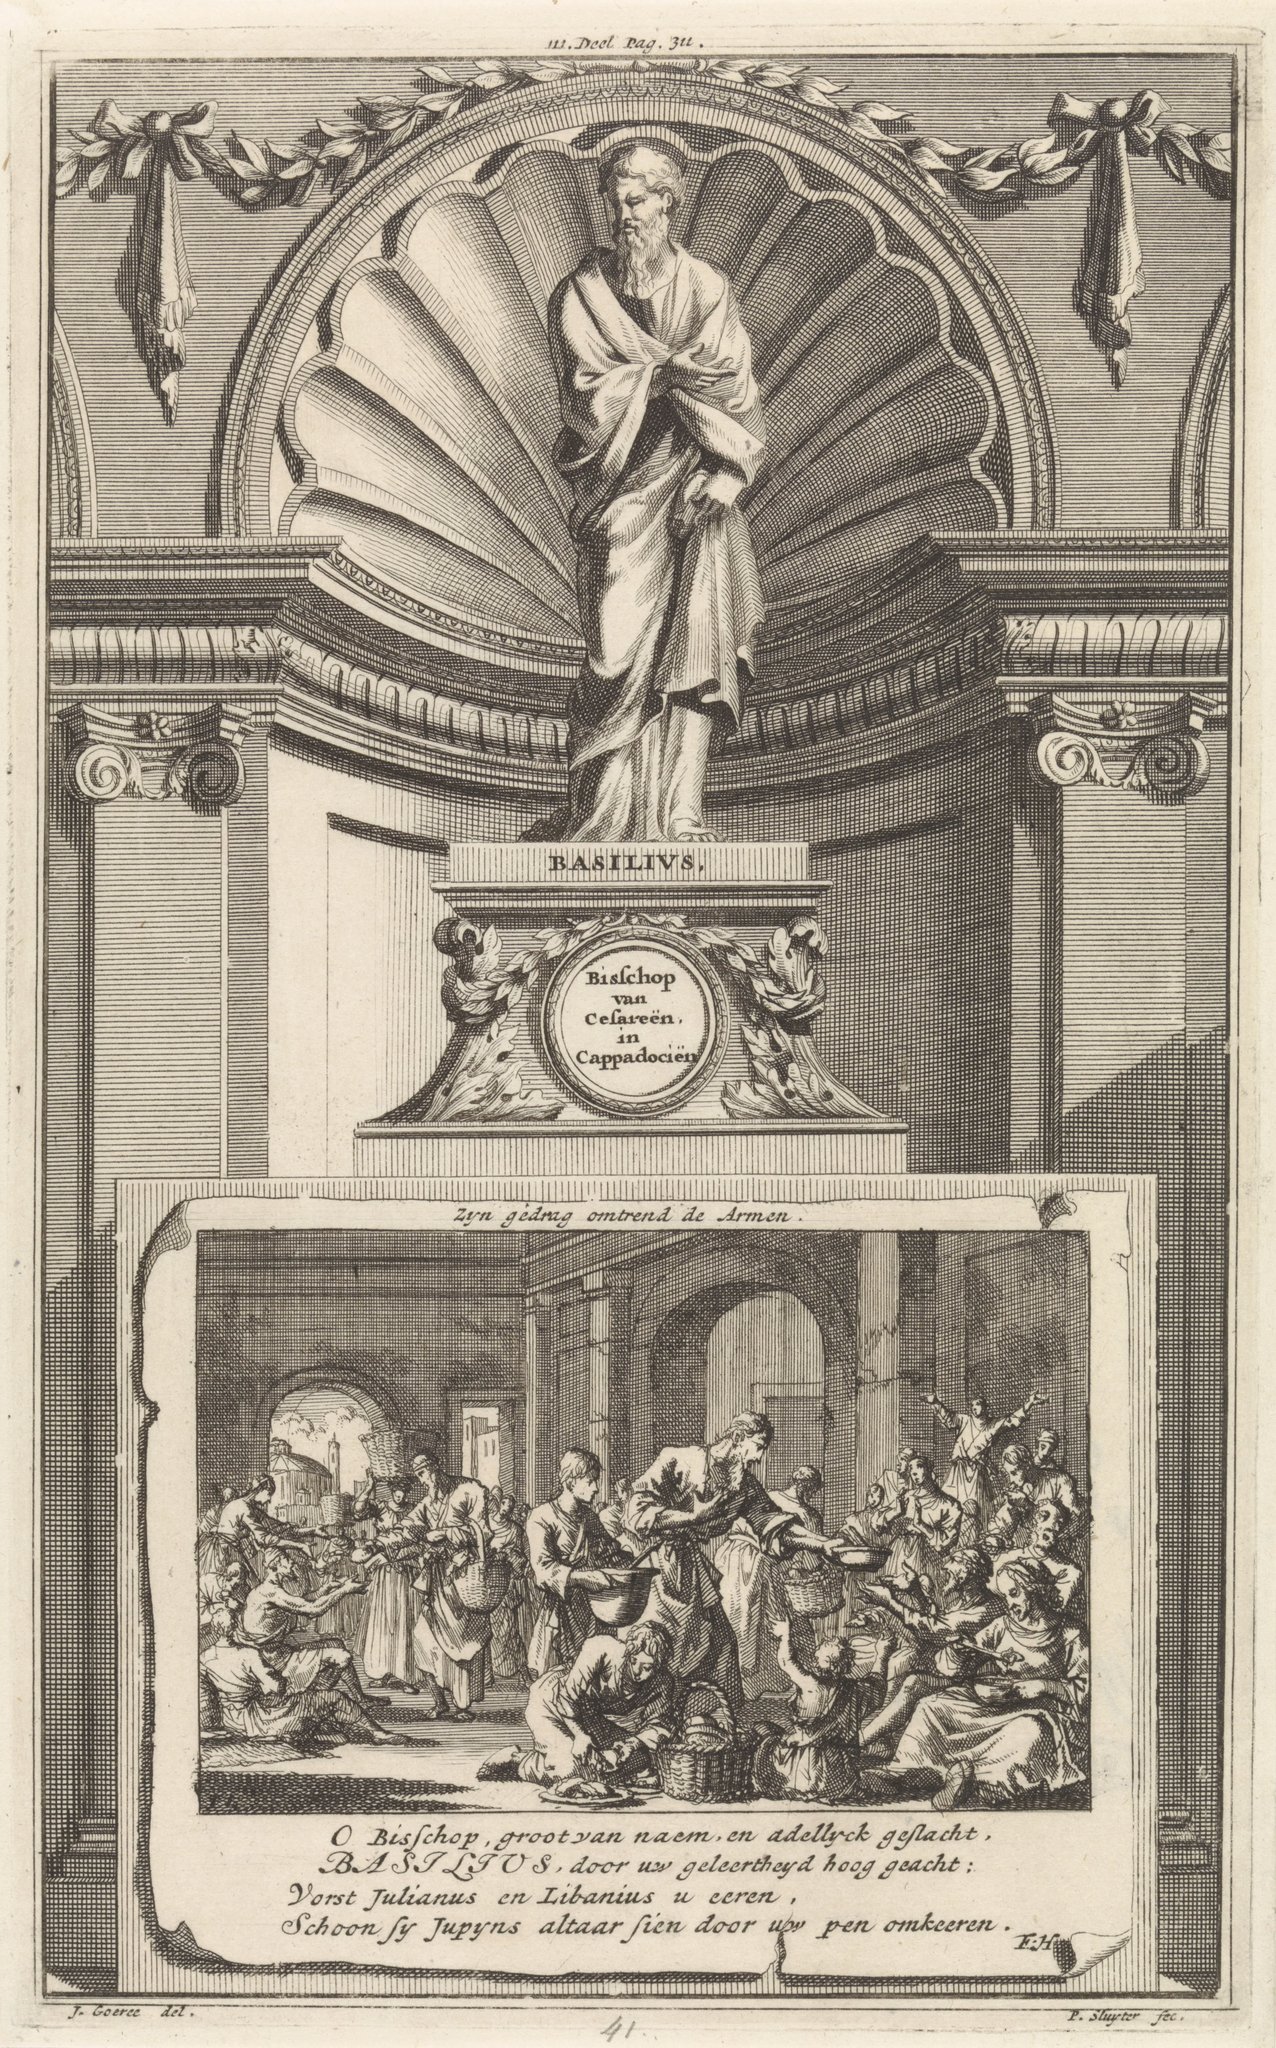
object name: print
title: H. Basilius van Caesarea, kerkvader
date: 1698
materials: paper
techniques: engraving, etching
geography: amsterdam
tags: giving alms or other charity, e.g.: handing out food, basil the great (basilius magnus), bishop of caesarea; possible attributes: dove, (column of) fire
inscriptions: number: ‘41’, collector's mark: Lugt 2228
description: De heilige kerkvader Basilius van Caesarea, staand op een sokkel. Op de voorzijde de scène waarin Basilius voedsel uitdeelt aan de armen. Prent middenboven gemerkt: III. Deel Pag. 311.